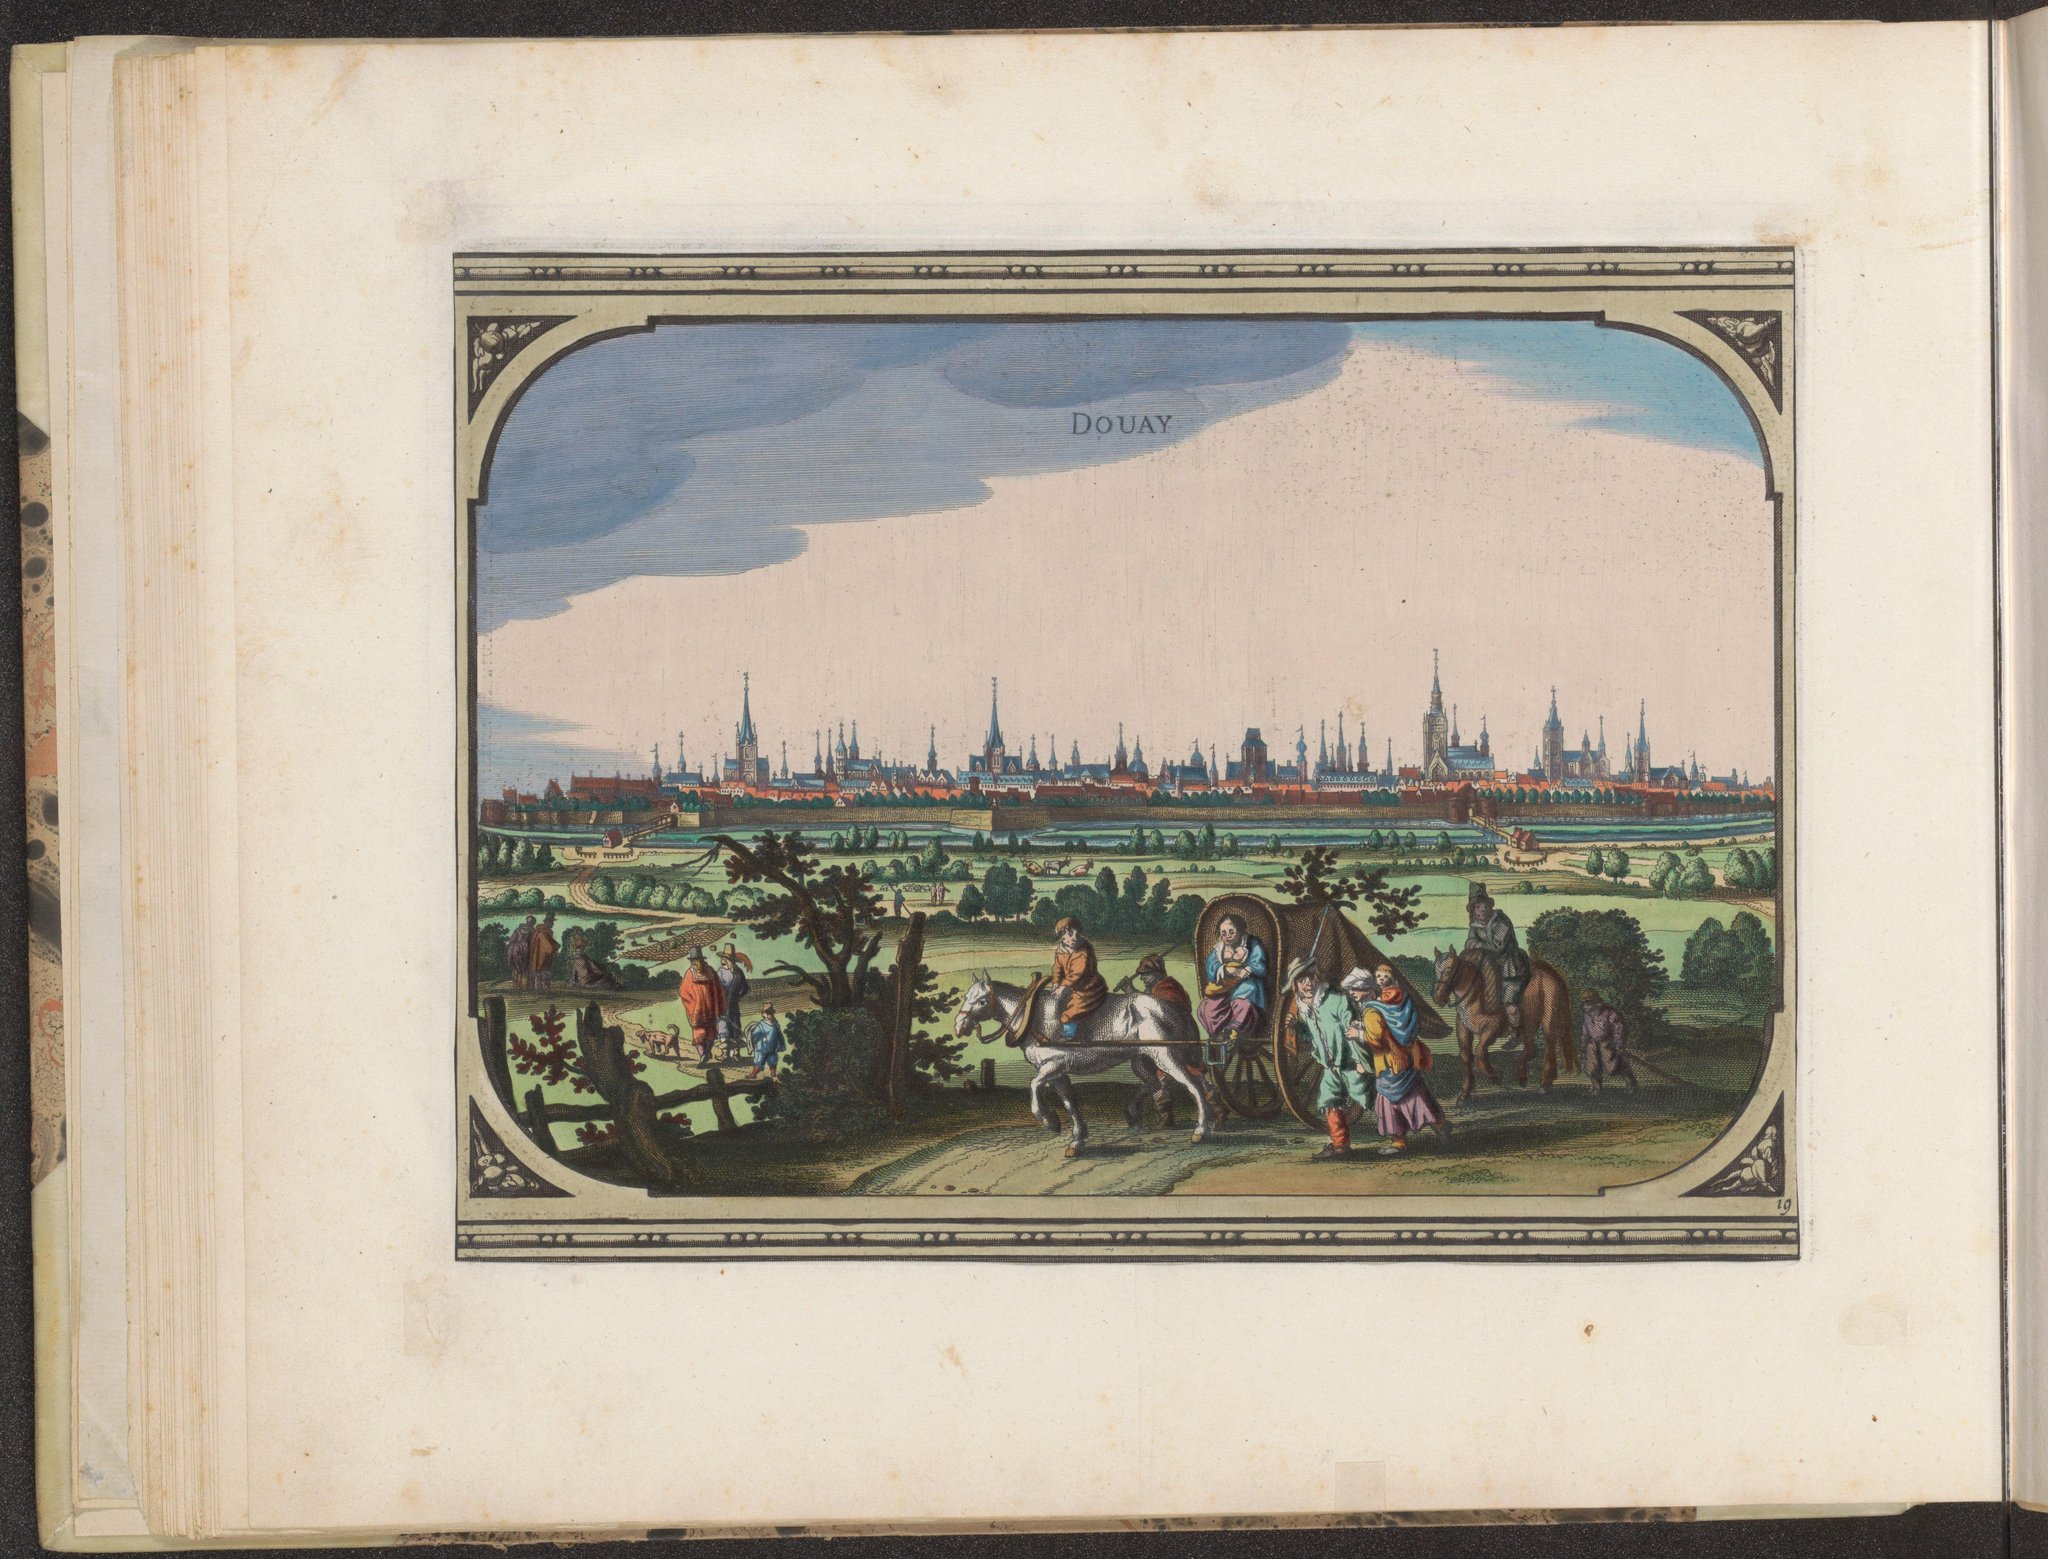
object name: album leaf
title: Gezicht op Douai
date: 1657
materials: paper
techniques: etching, hand coloring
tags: city-view, and landscape with man-made constructions, two-wheeled, animal-drawn vehicle, 'en route', traveller under way, carrying a child on the back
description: Gezicht op de stad Douai. Op de voorgrond zit een vrouw in een huifkar getrokken door één paard. Op de rug van het paard een jongen. Ernaast onder meer een man met een geweer over zijn schouder en een vrouw met een kind op haar rug. De prent maakt deel uit van een album.